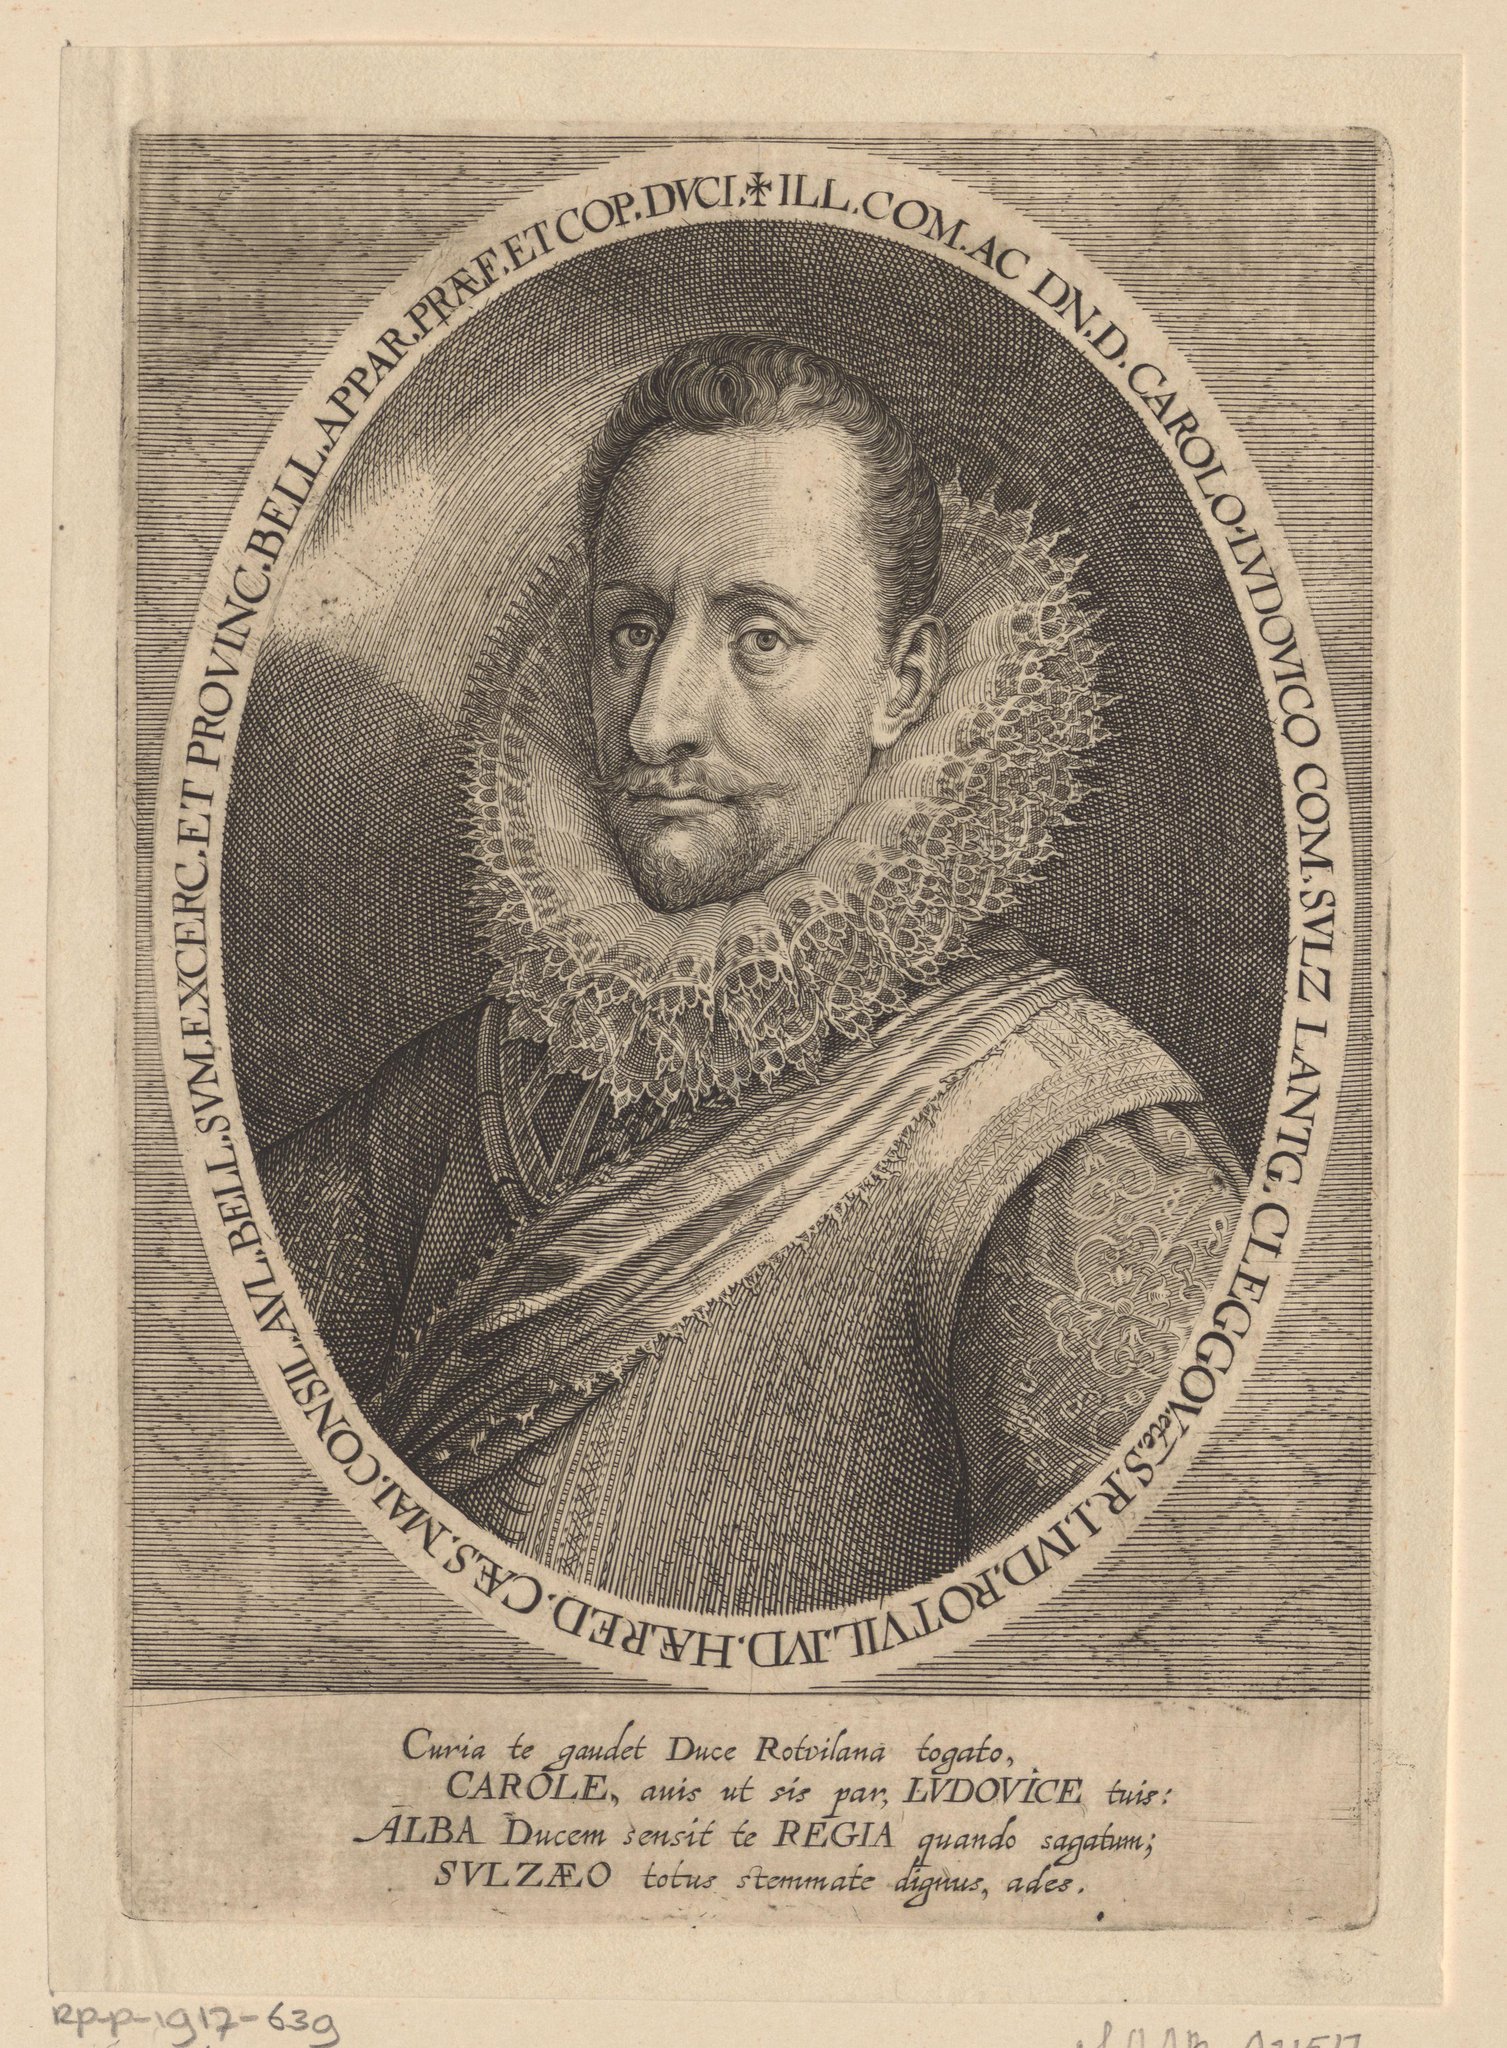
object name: print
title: Portret van Carl Ludwig, graaf van Sulz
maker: Anonymous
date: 1600-1700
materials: paper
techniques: engraving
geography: germany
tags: commander-in-chief, general, marshal, historical persons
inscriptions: collector's mark: Lugt 2228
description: Onder het portret een vierregelig onderschrift in het Latijn.